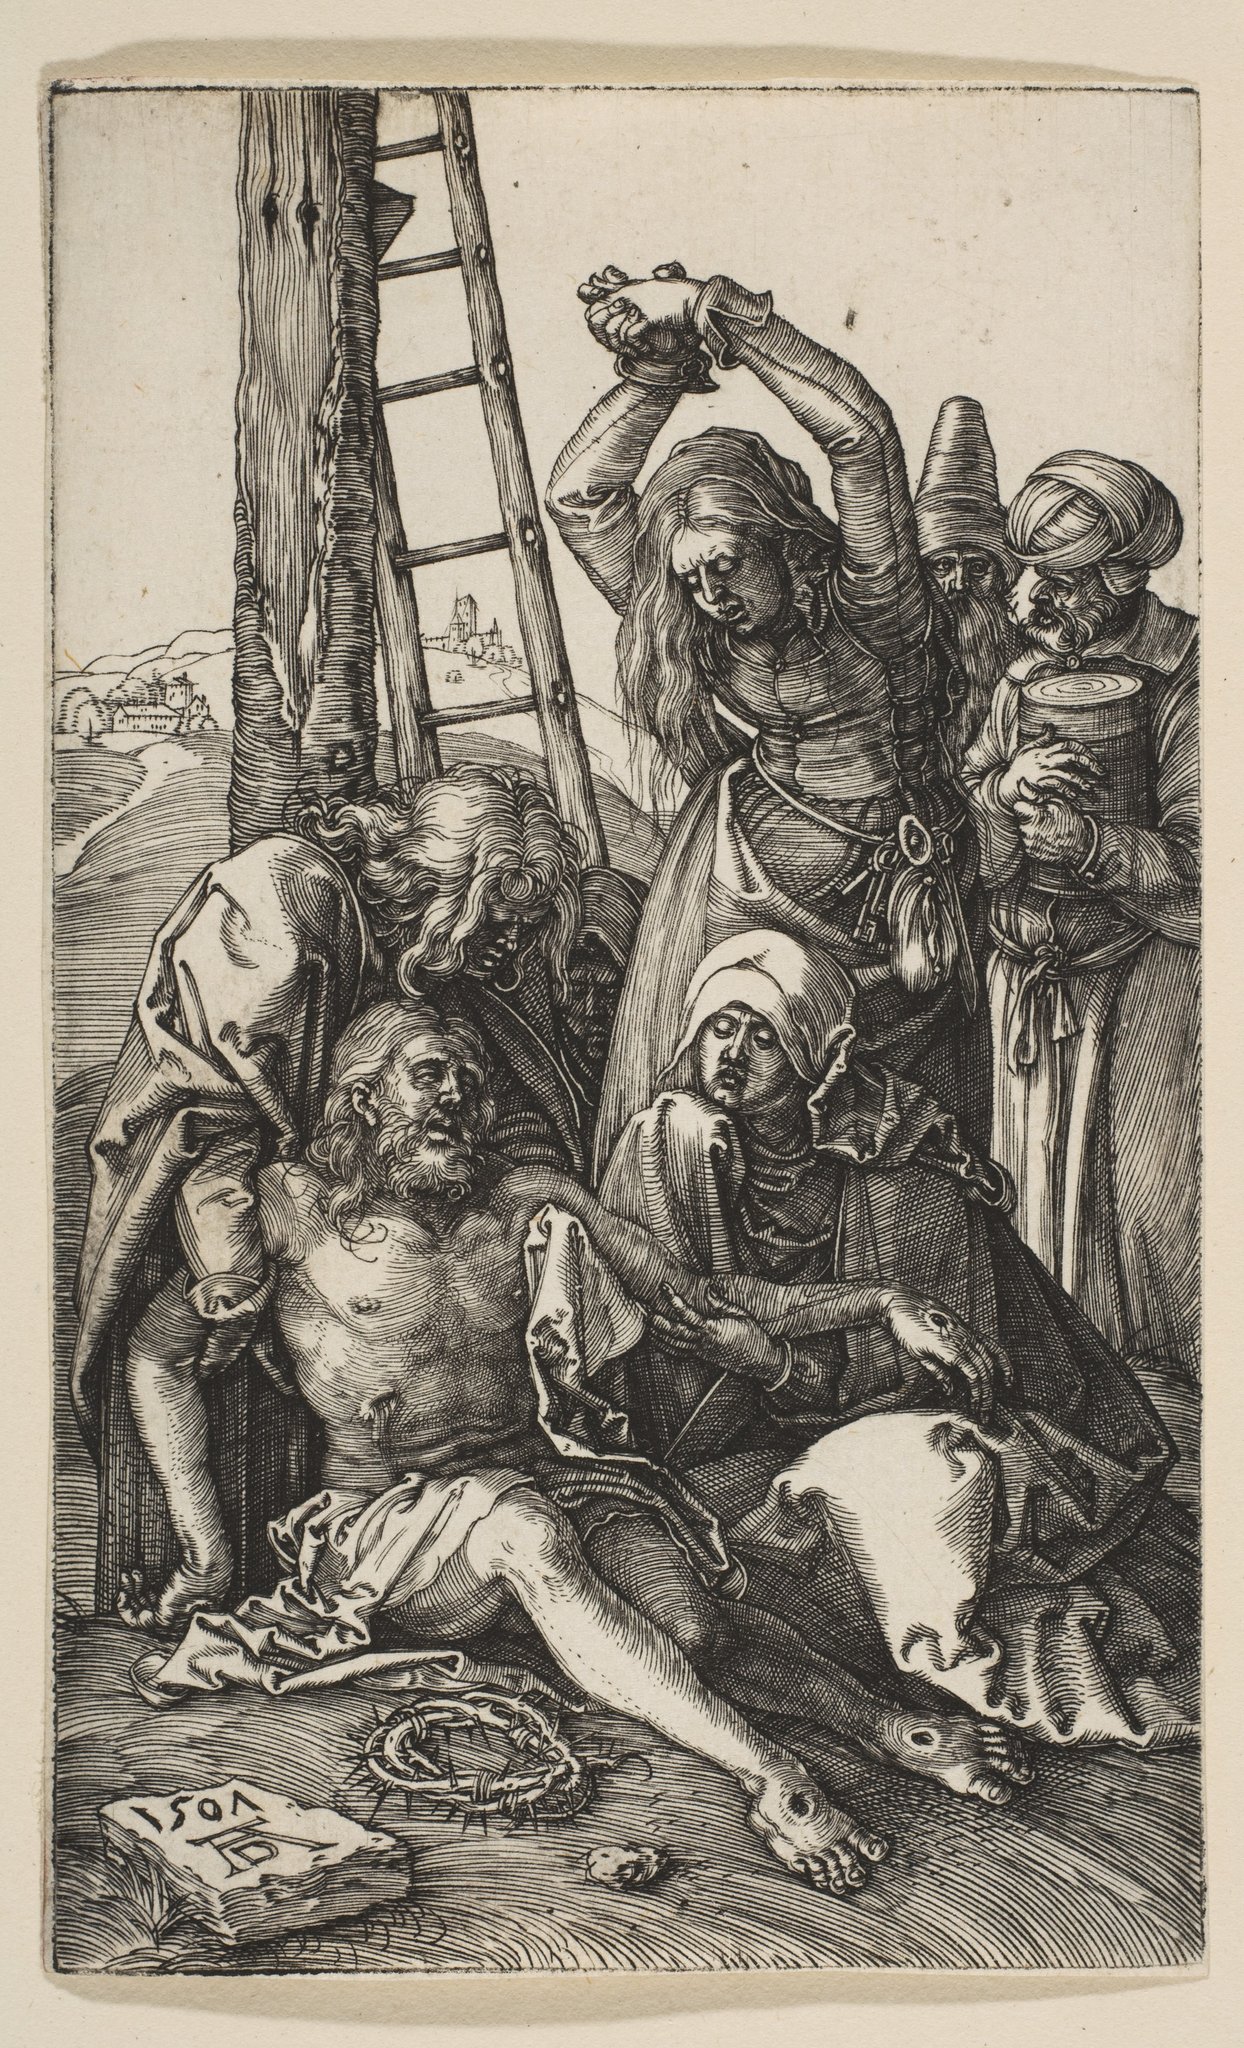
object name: print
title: The Lamentation, from "The Passion"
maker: albrecht dürer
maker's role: artist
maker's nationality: german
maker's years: 1471-1528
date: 1507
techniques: engraving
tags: men,women,christ,lamentation